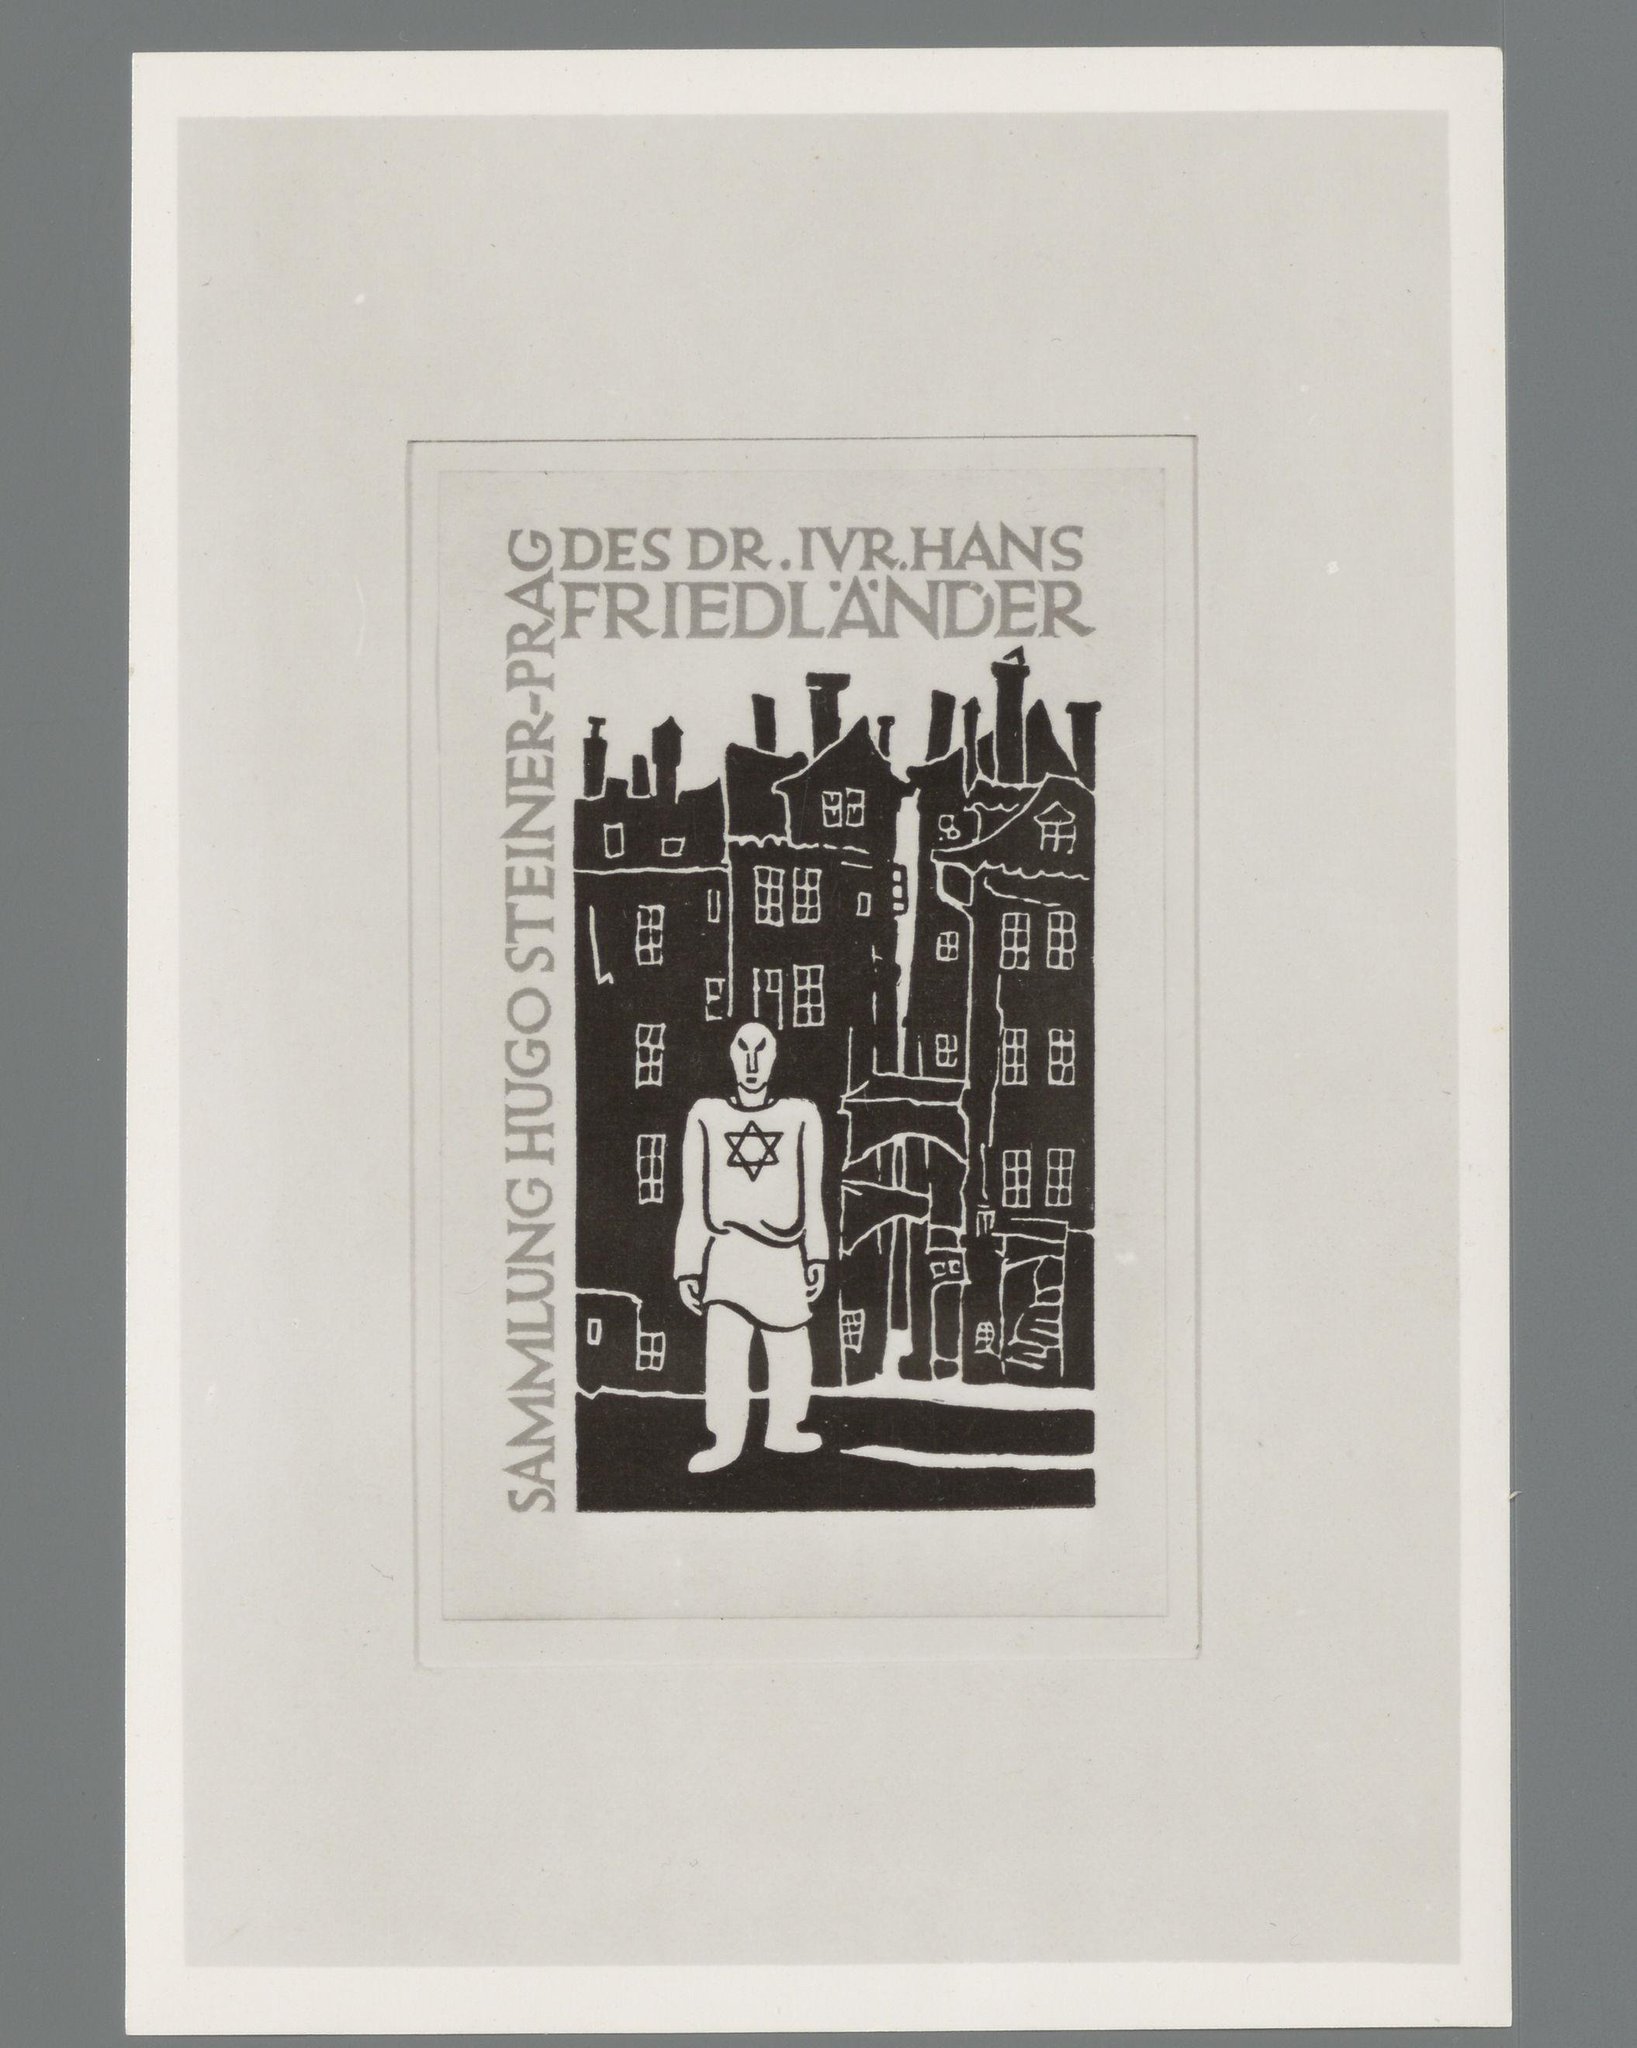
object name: bookplate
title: Ex libris van Hans Friedländer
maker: Anonymous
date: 1937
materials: paper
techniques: gelatin silver print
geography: germany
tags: urban housing, standing figure, jewish religion and culture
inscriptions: inscription: ‘Bookplate by / Hugo Steiner-Prag / (Ab. 1935-40) / 1937? / original size / Collection / Charles Gl. Behrens / Stockholm’